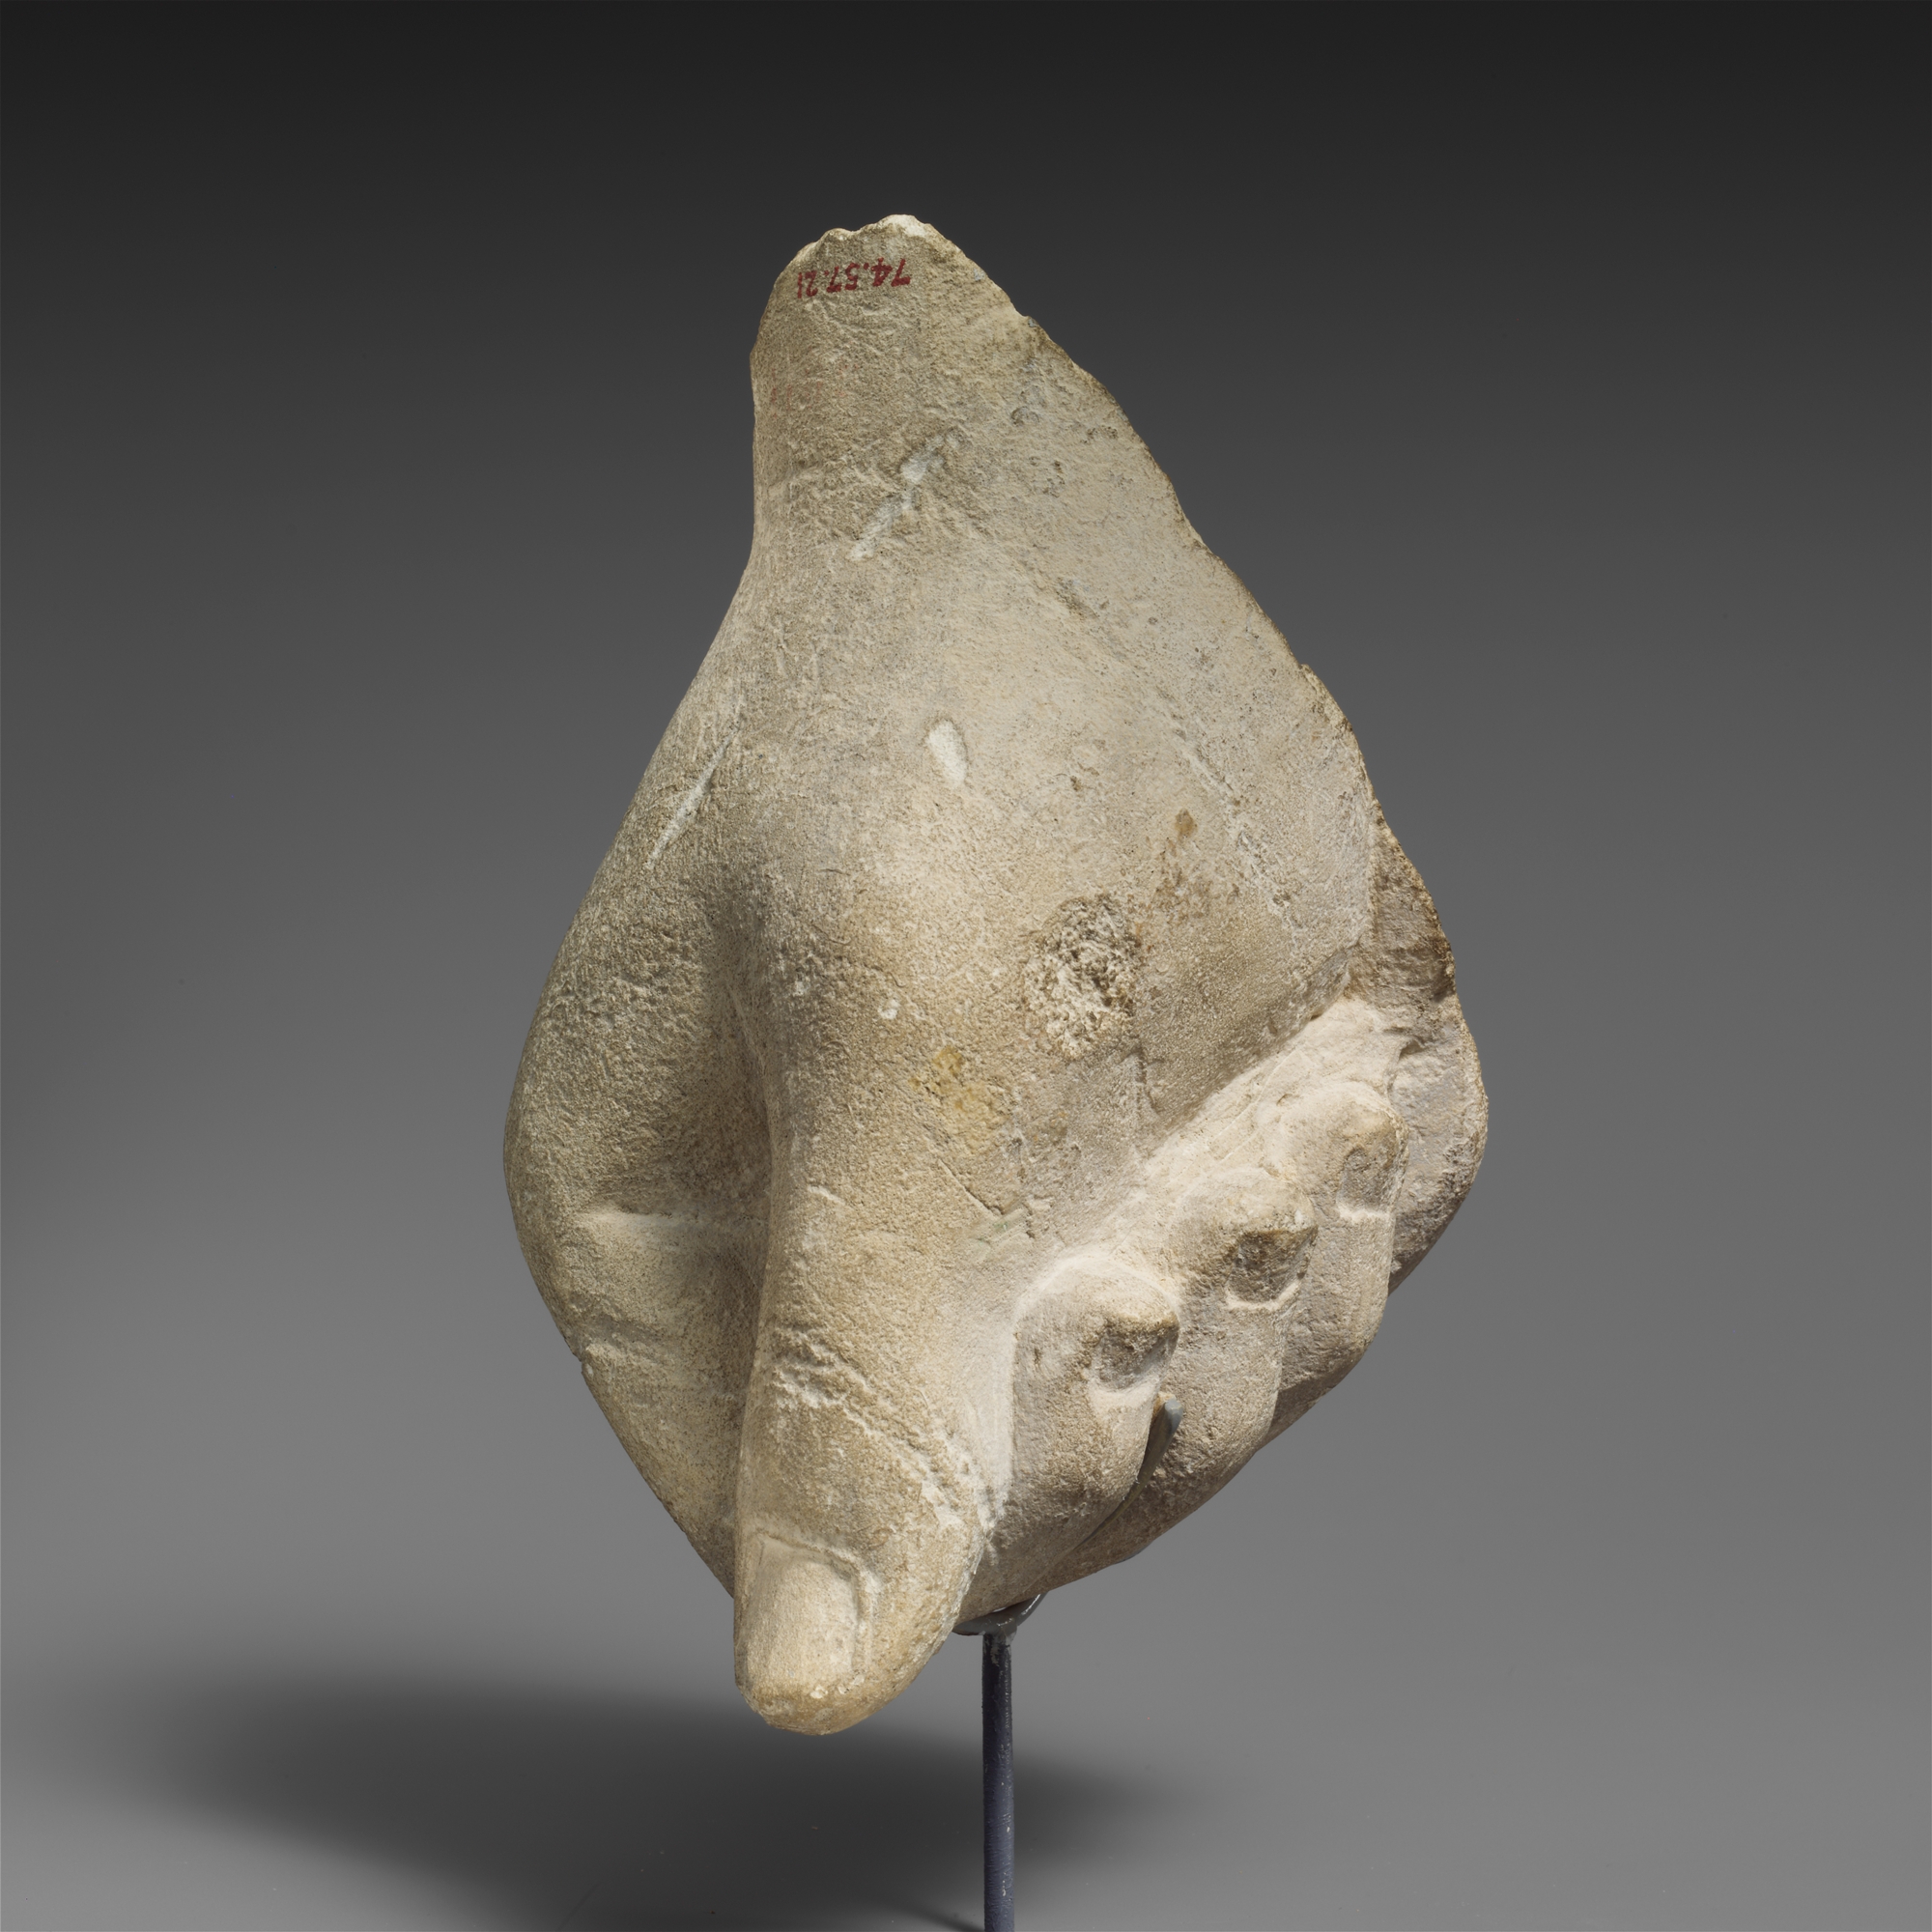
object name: hand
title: Limestone hand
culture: roman, cypriot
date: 300-1 BCE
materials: limestone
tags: hands